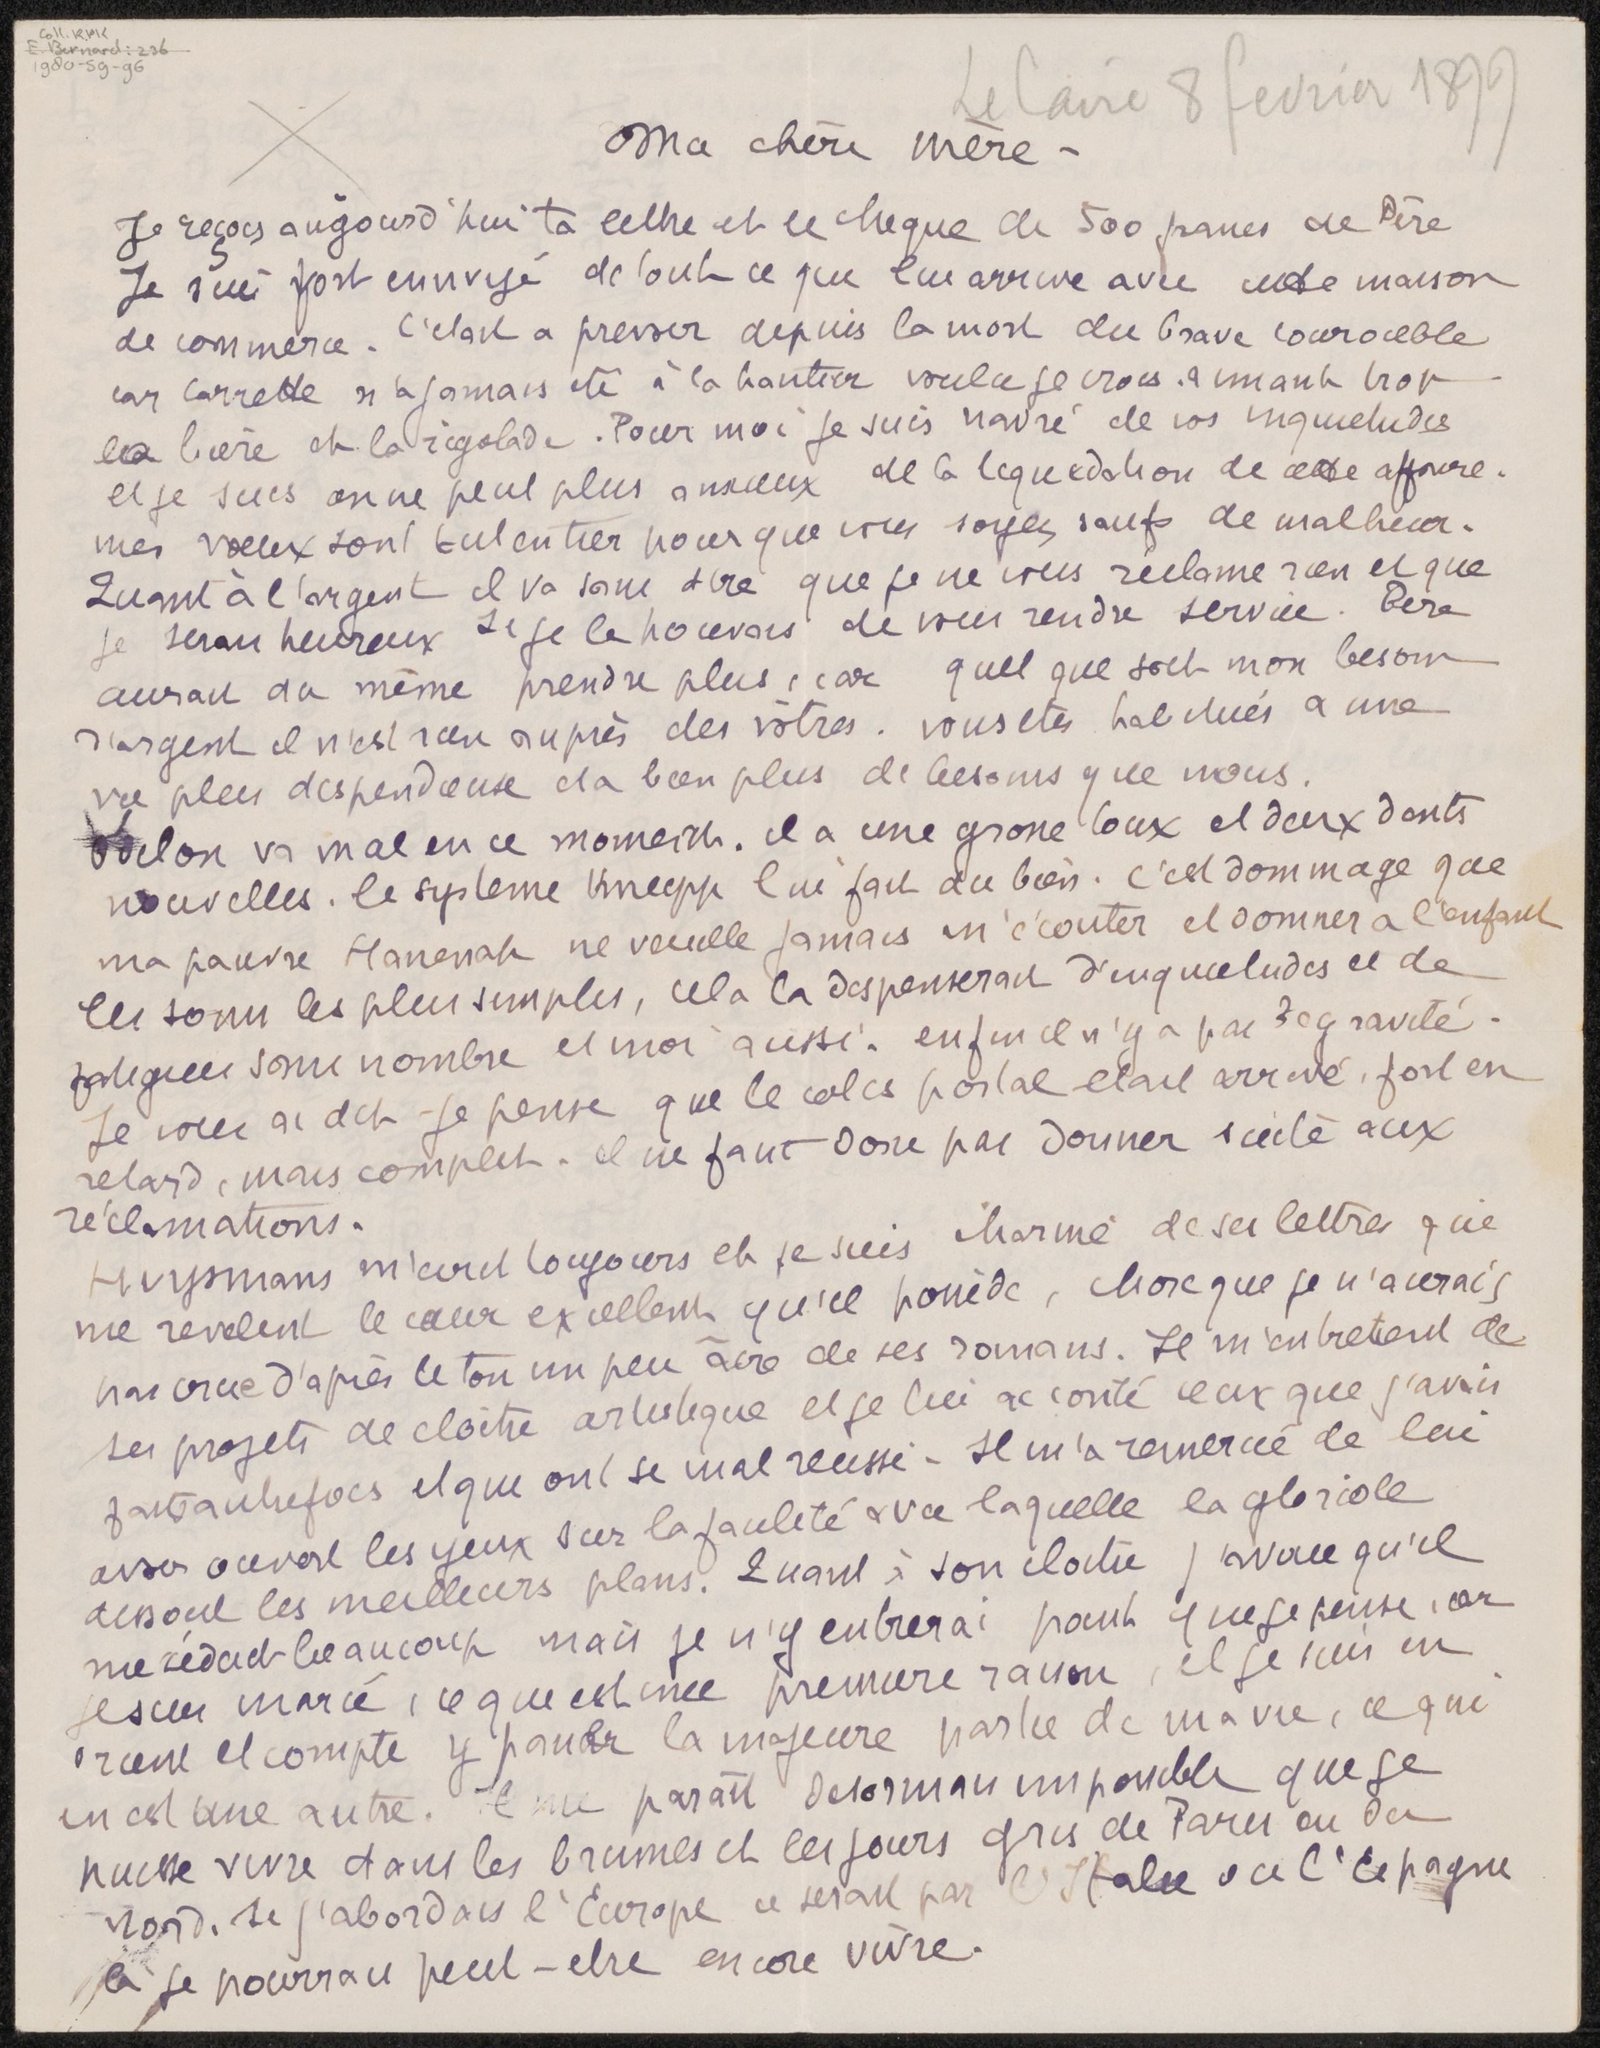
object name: letter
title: Brief aan Héloïse Bernard-Bodin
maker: émile bernard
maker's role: print maker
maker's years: 1868-1941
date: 1899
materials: ink, paper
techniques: pen, writing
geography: cairo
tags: héloïse bernard-bodin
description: Brief gedateerd 8 fevrier 1899 in latere hand.